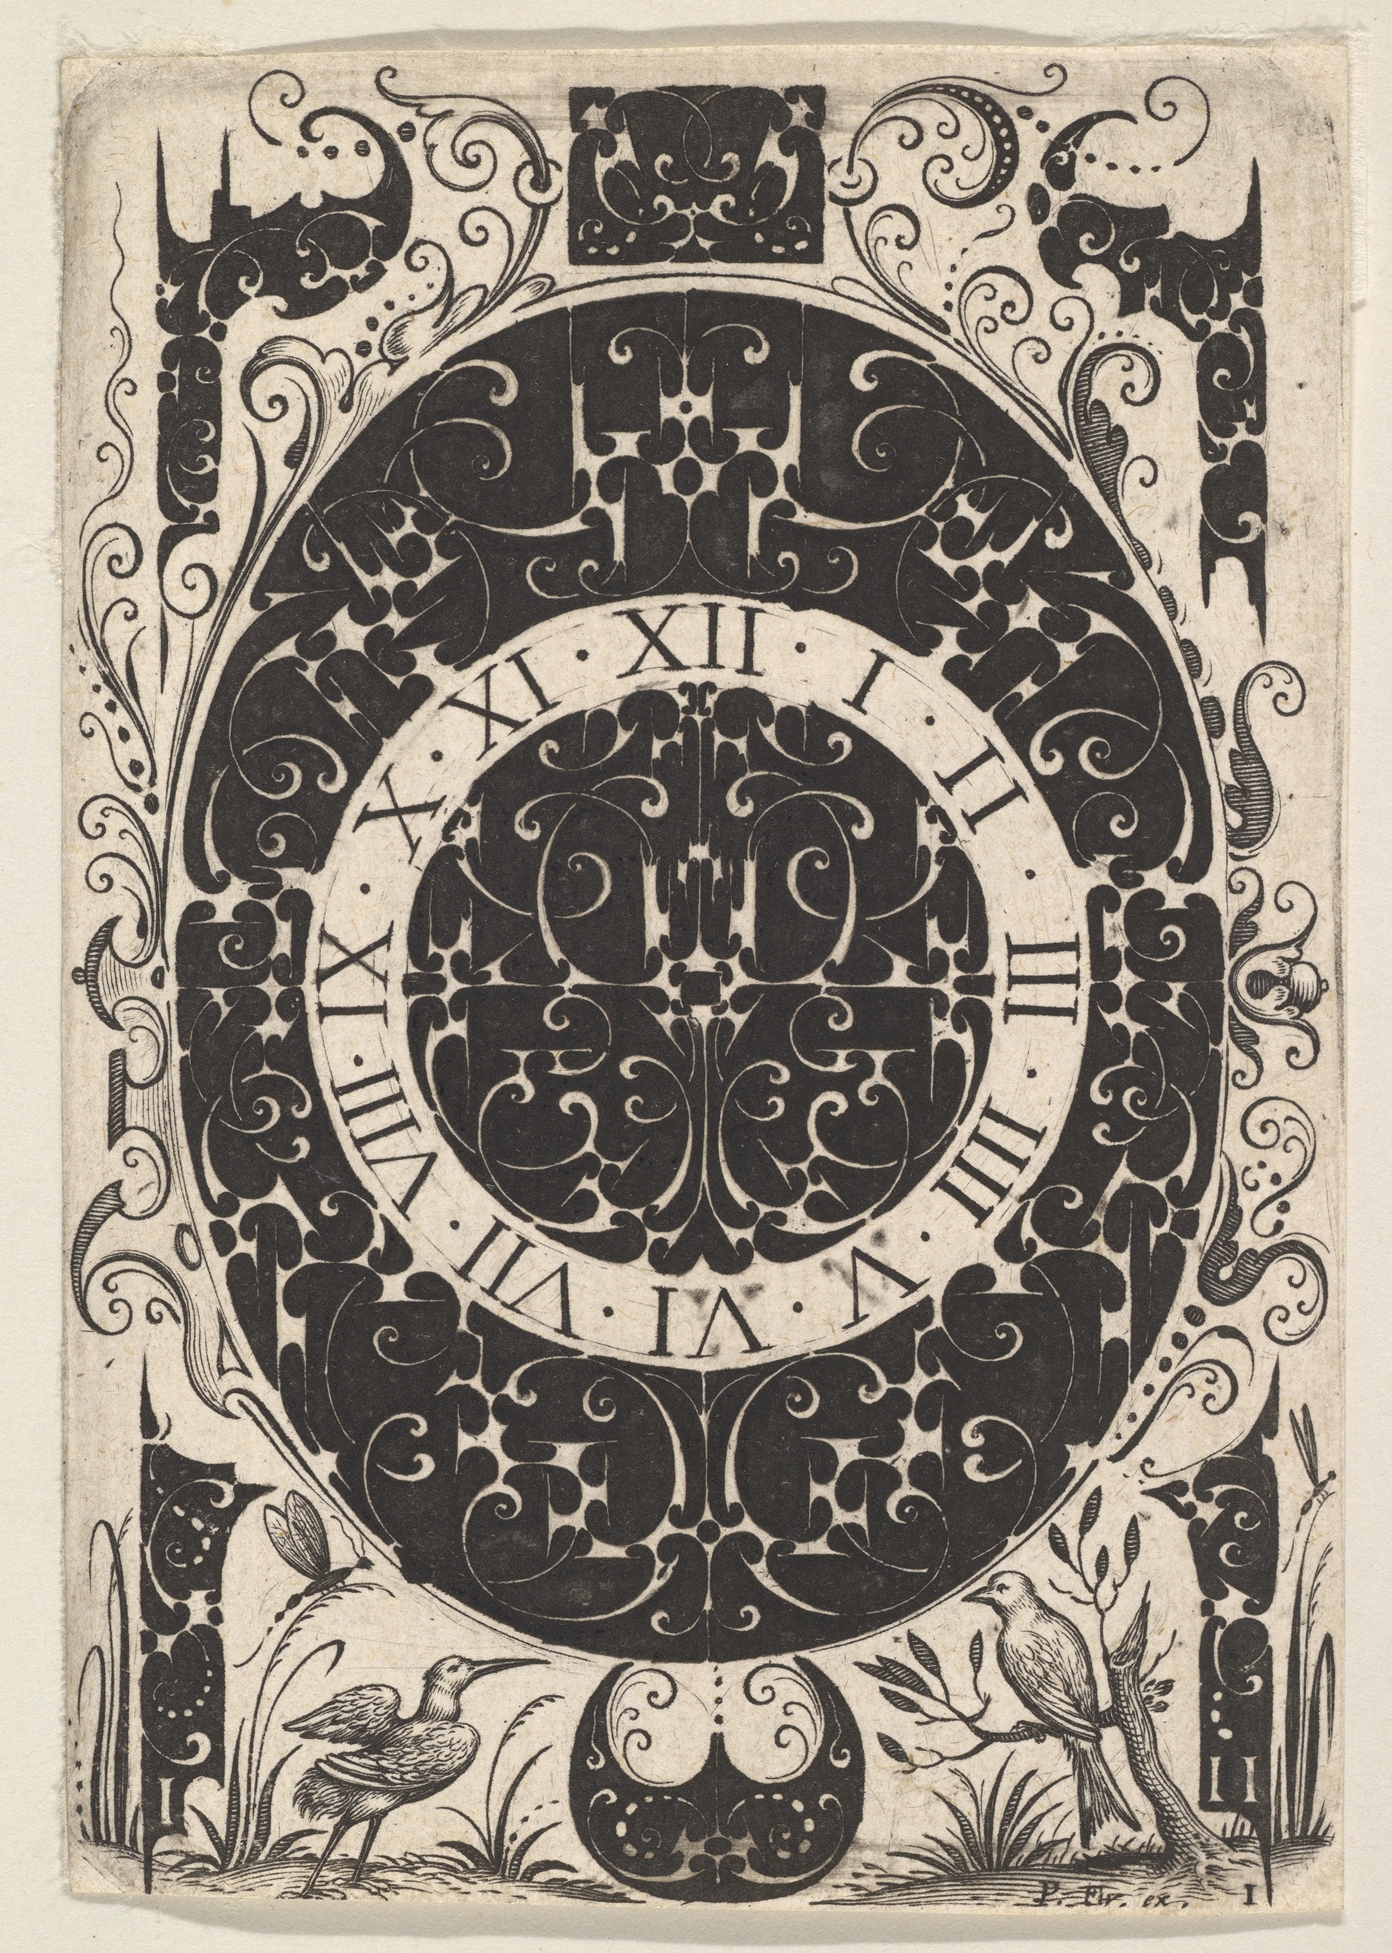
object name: print collection ornament architecture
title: Oval Watchcase with Birds and Smaller Motifs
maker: jacques hurtu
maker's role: artist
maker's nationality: french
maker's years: 1584-1635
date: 1614-1619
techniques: embroidery, engraving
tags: birds,watches